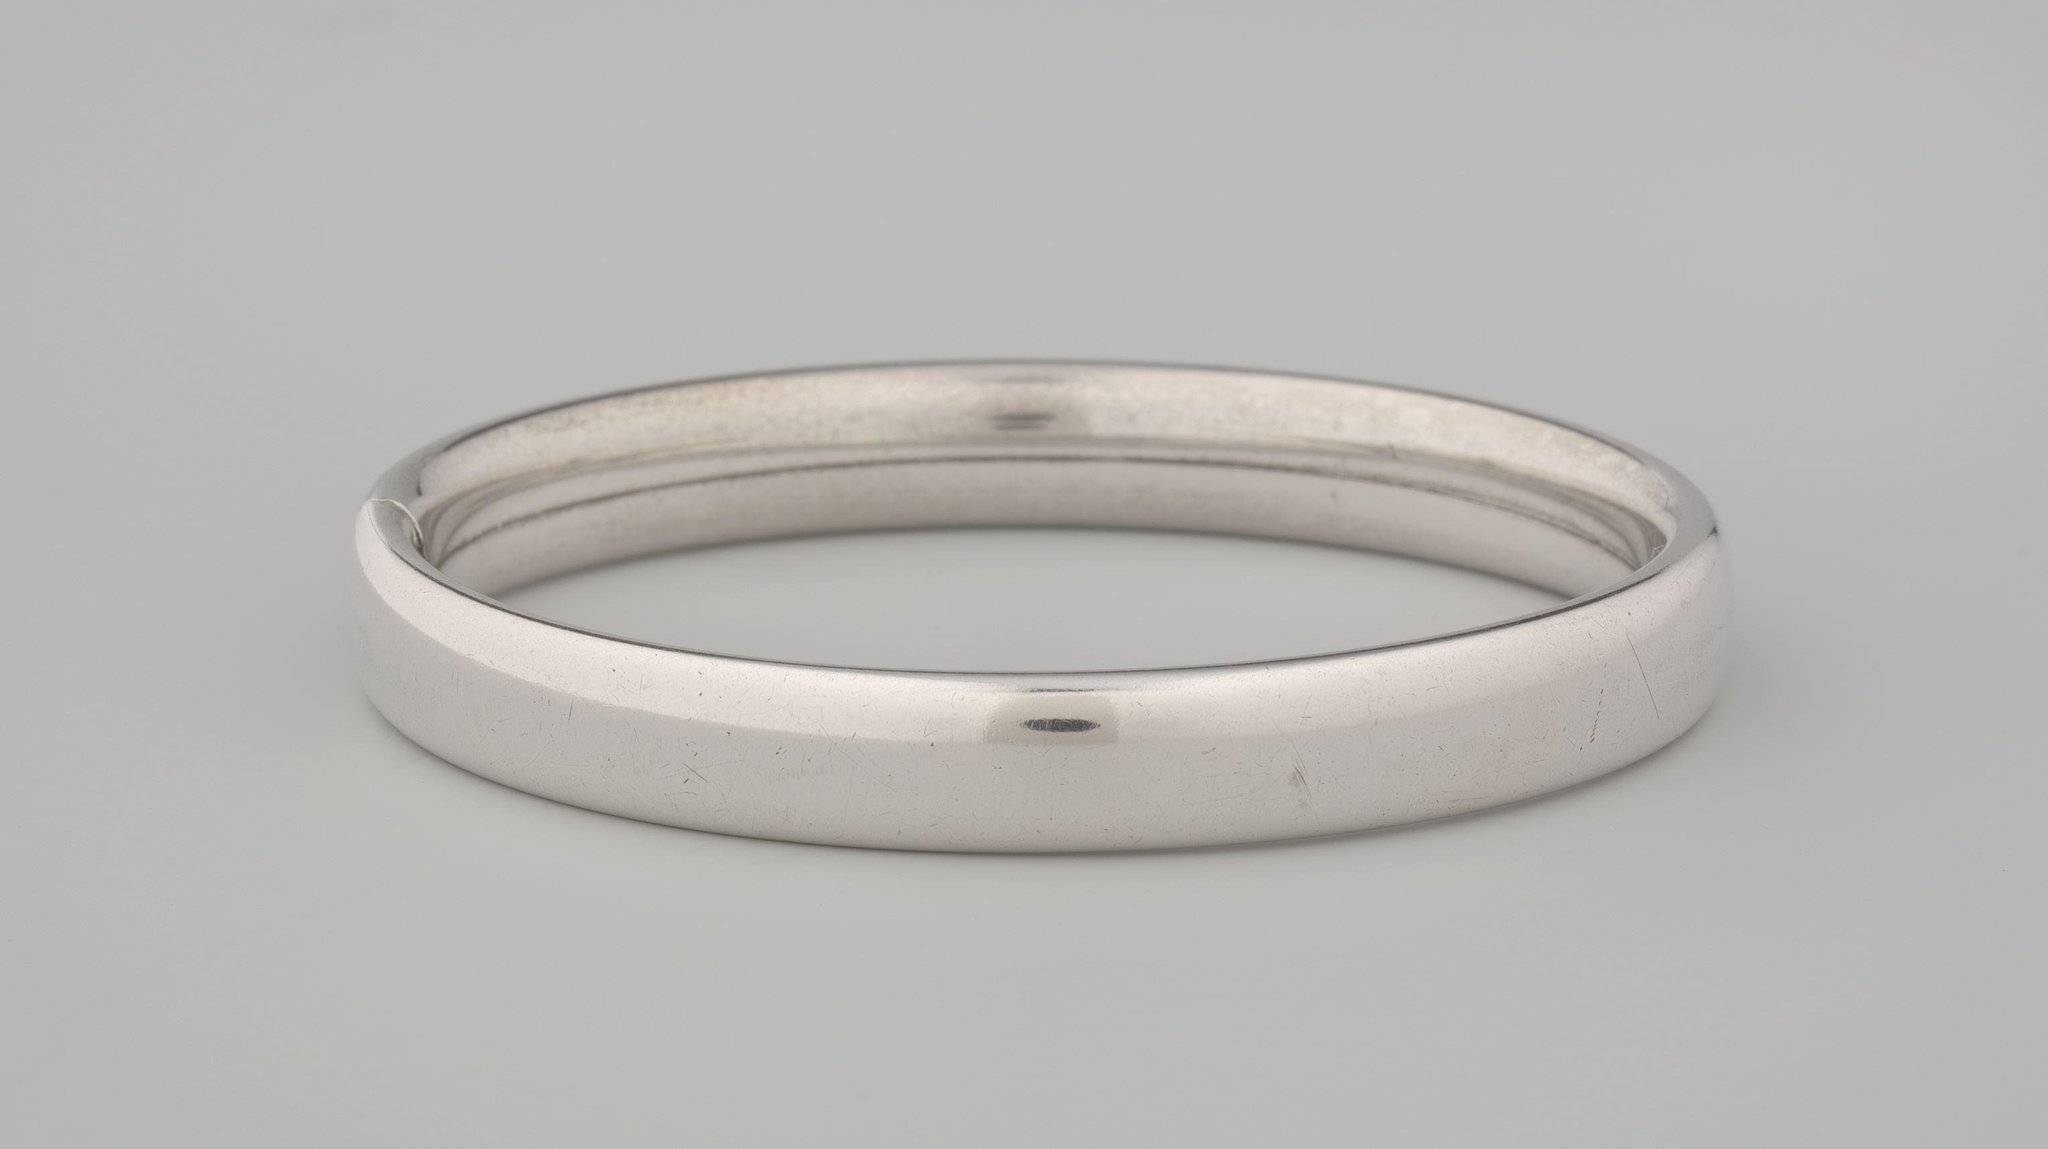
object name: bracelet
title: Slavenarmband van zilver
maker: Anonymous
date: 1960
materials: silver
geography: netherlands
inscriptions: alloy mark: ‘zwaard 835’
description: Slavenarmband van zilver. De armband is gedragen door Marjan Unger.